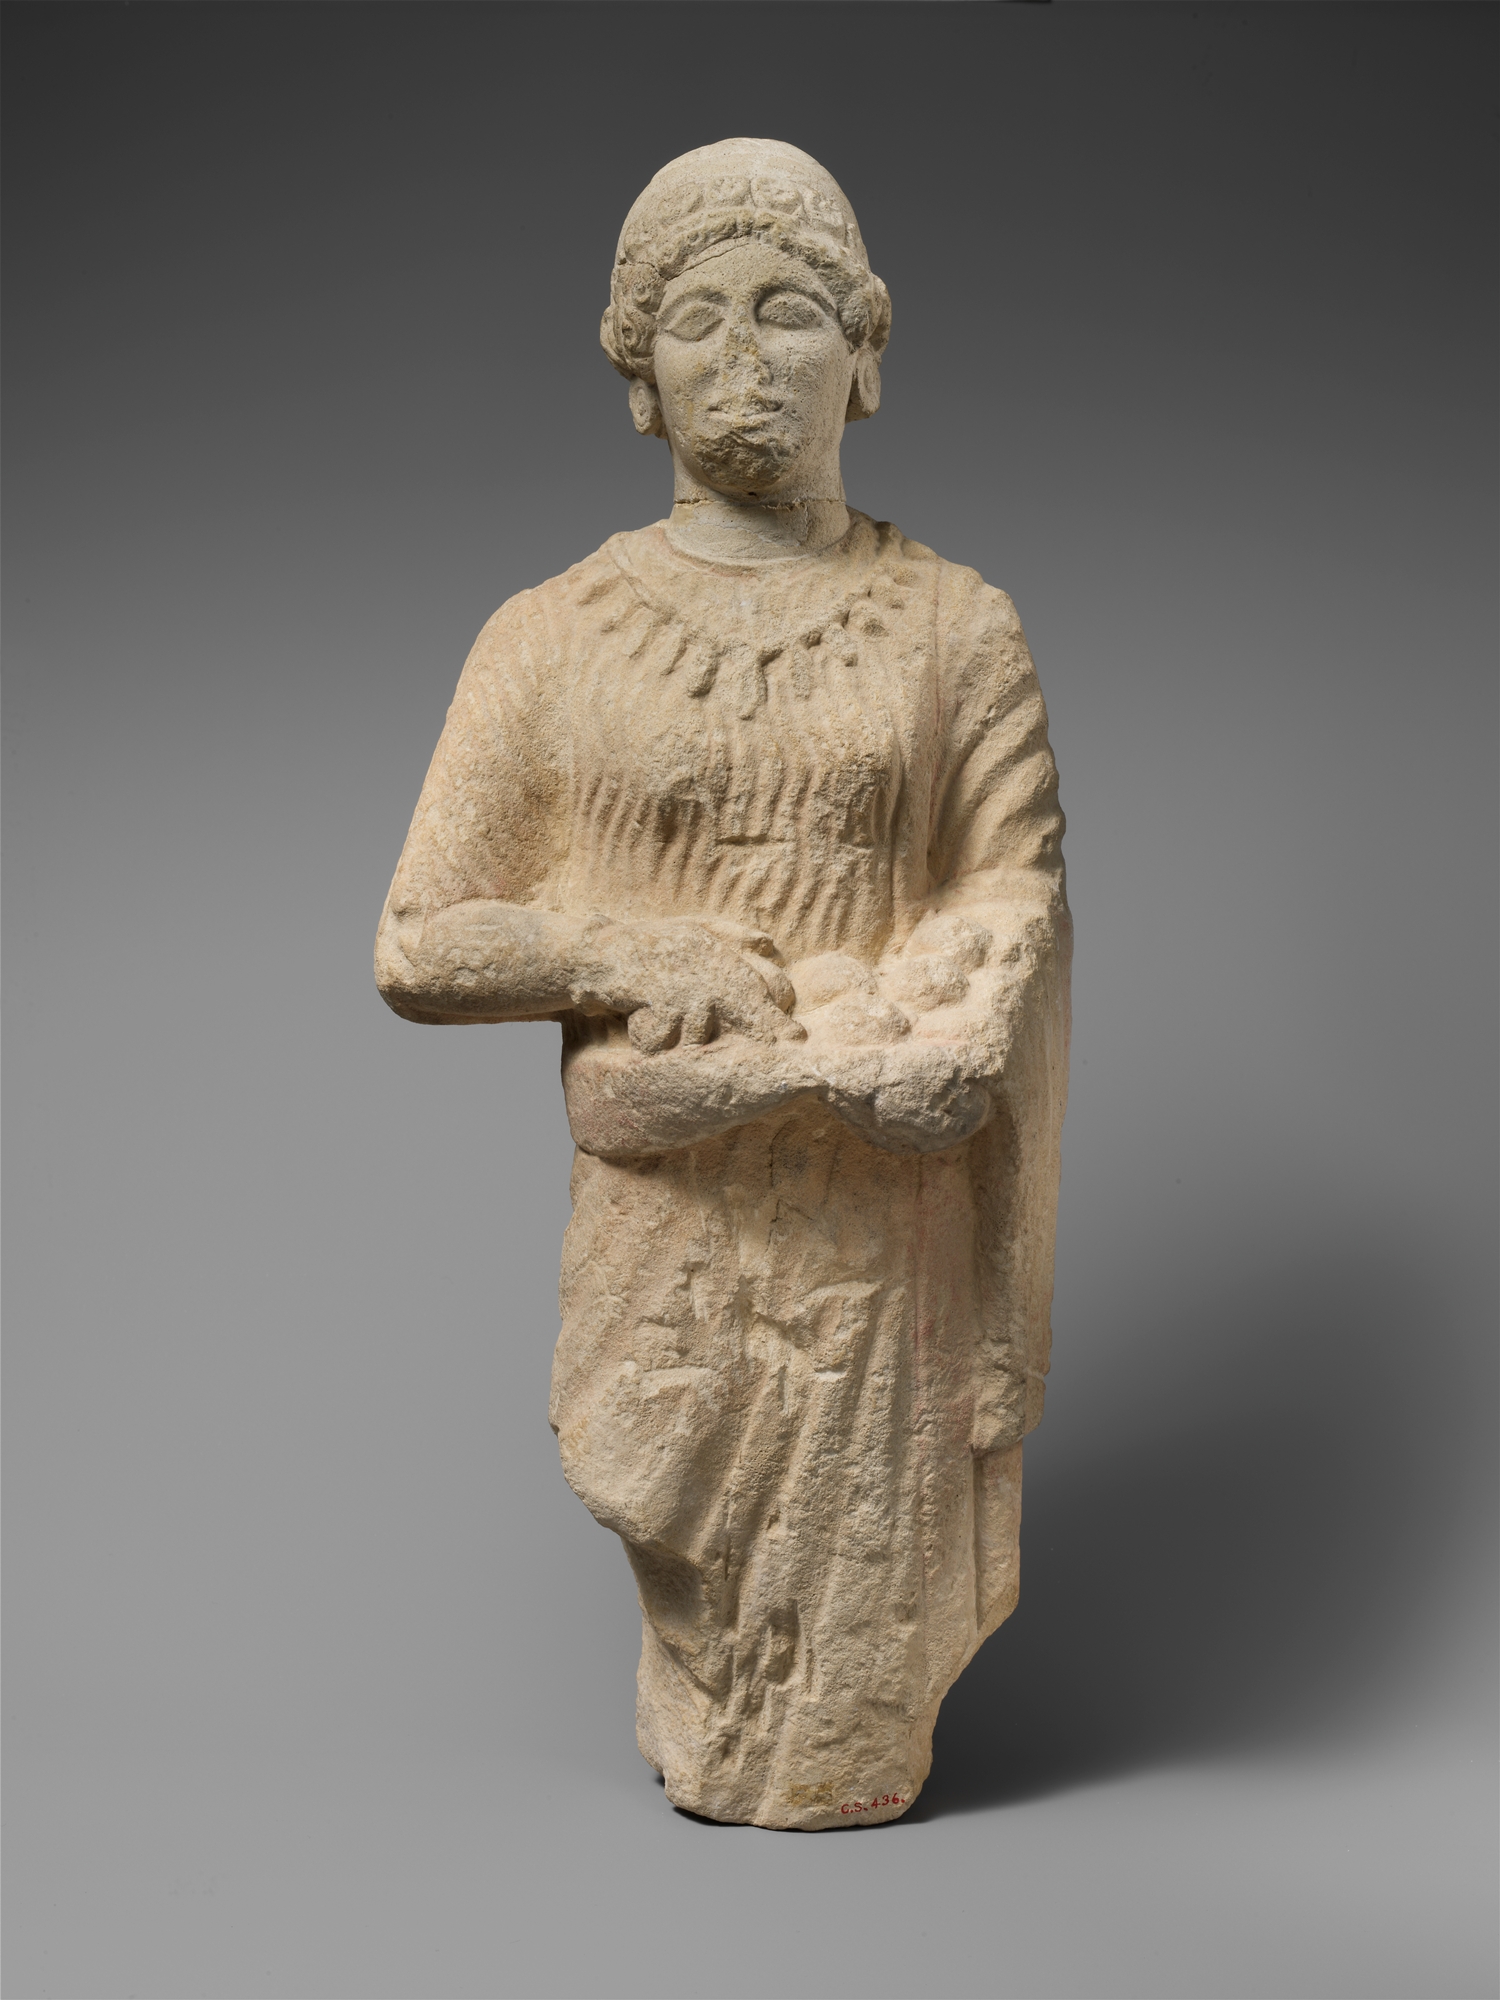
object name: statue of a votary, female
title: Limestone statuette of a female votary holding pieces of fruit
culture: cypriot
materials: limestone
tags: fruit,women